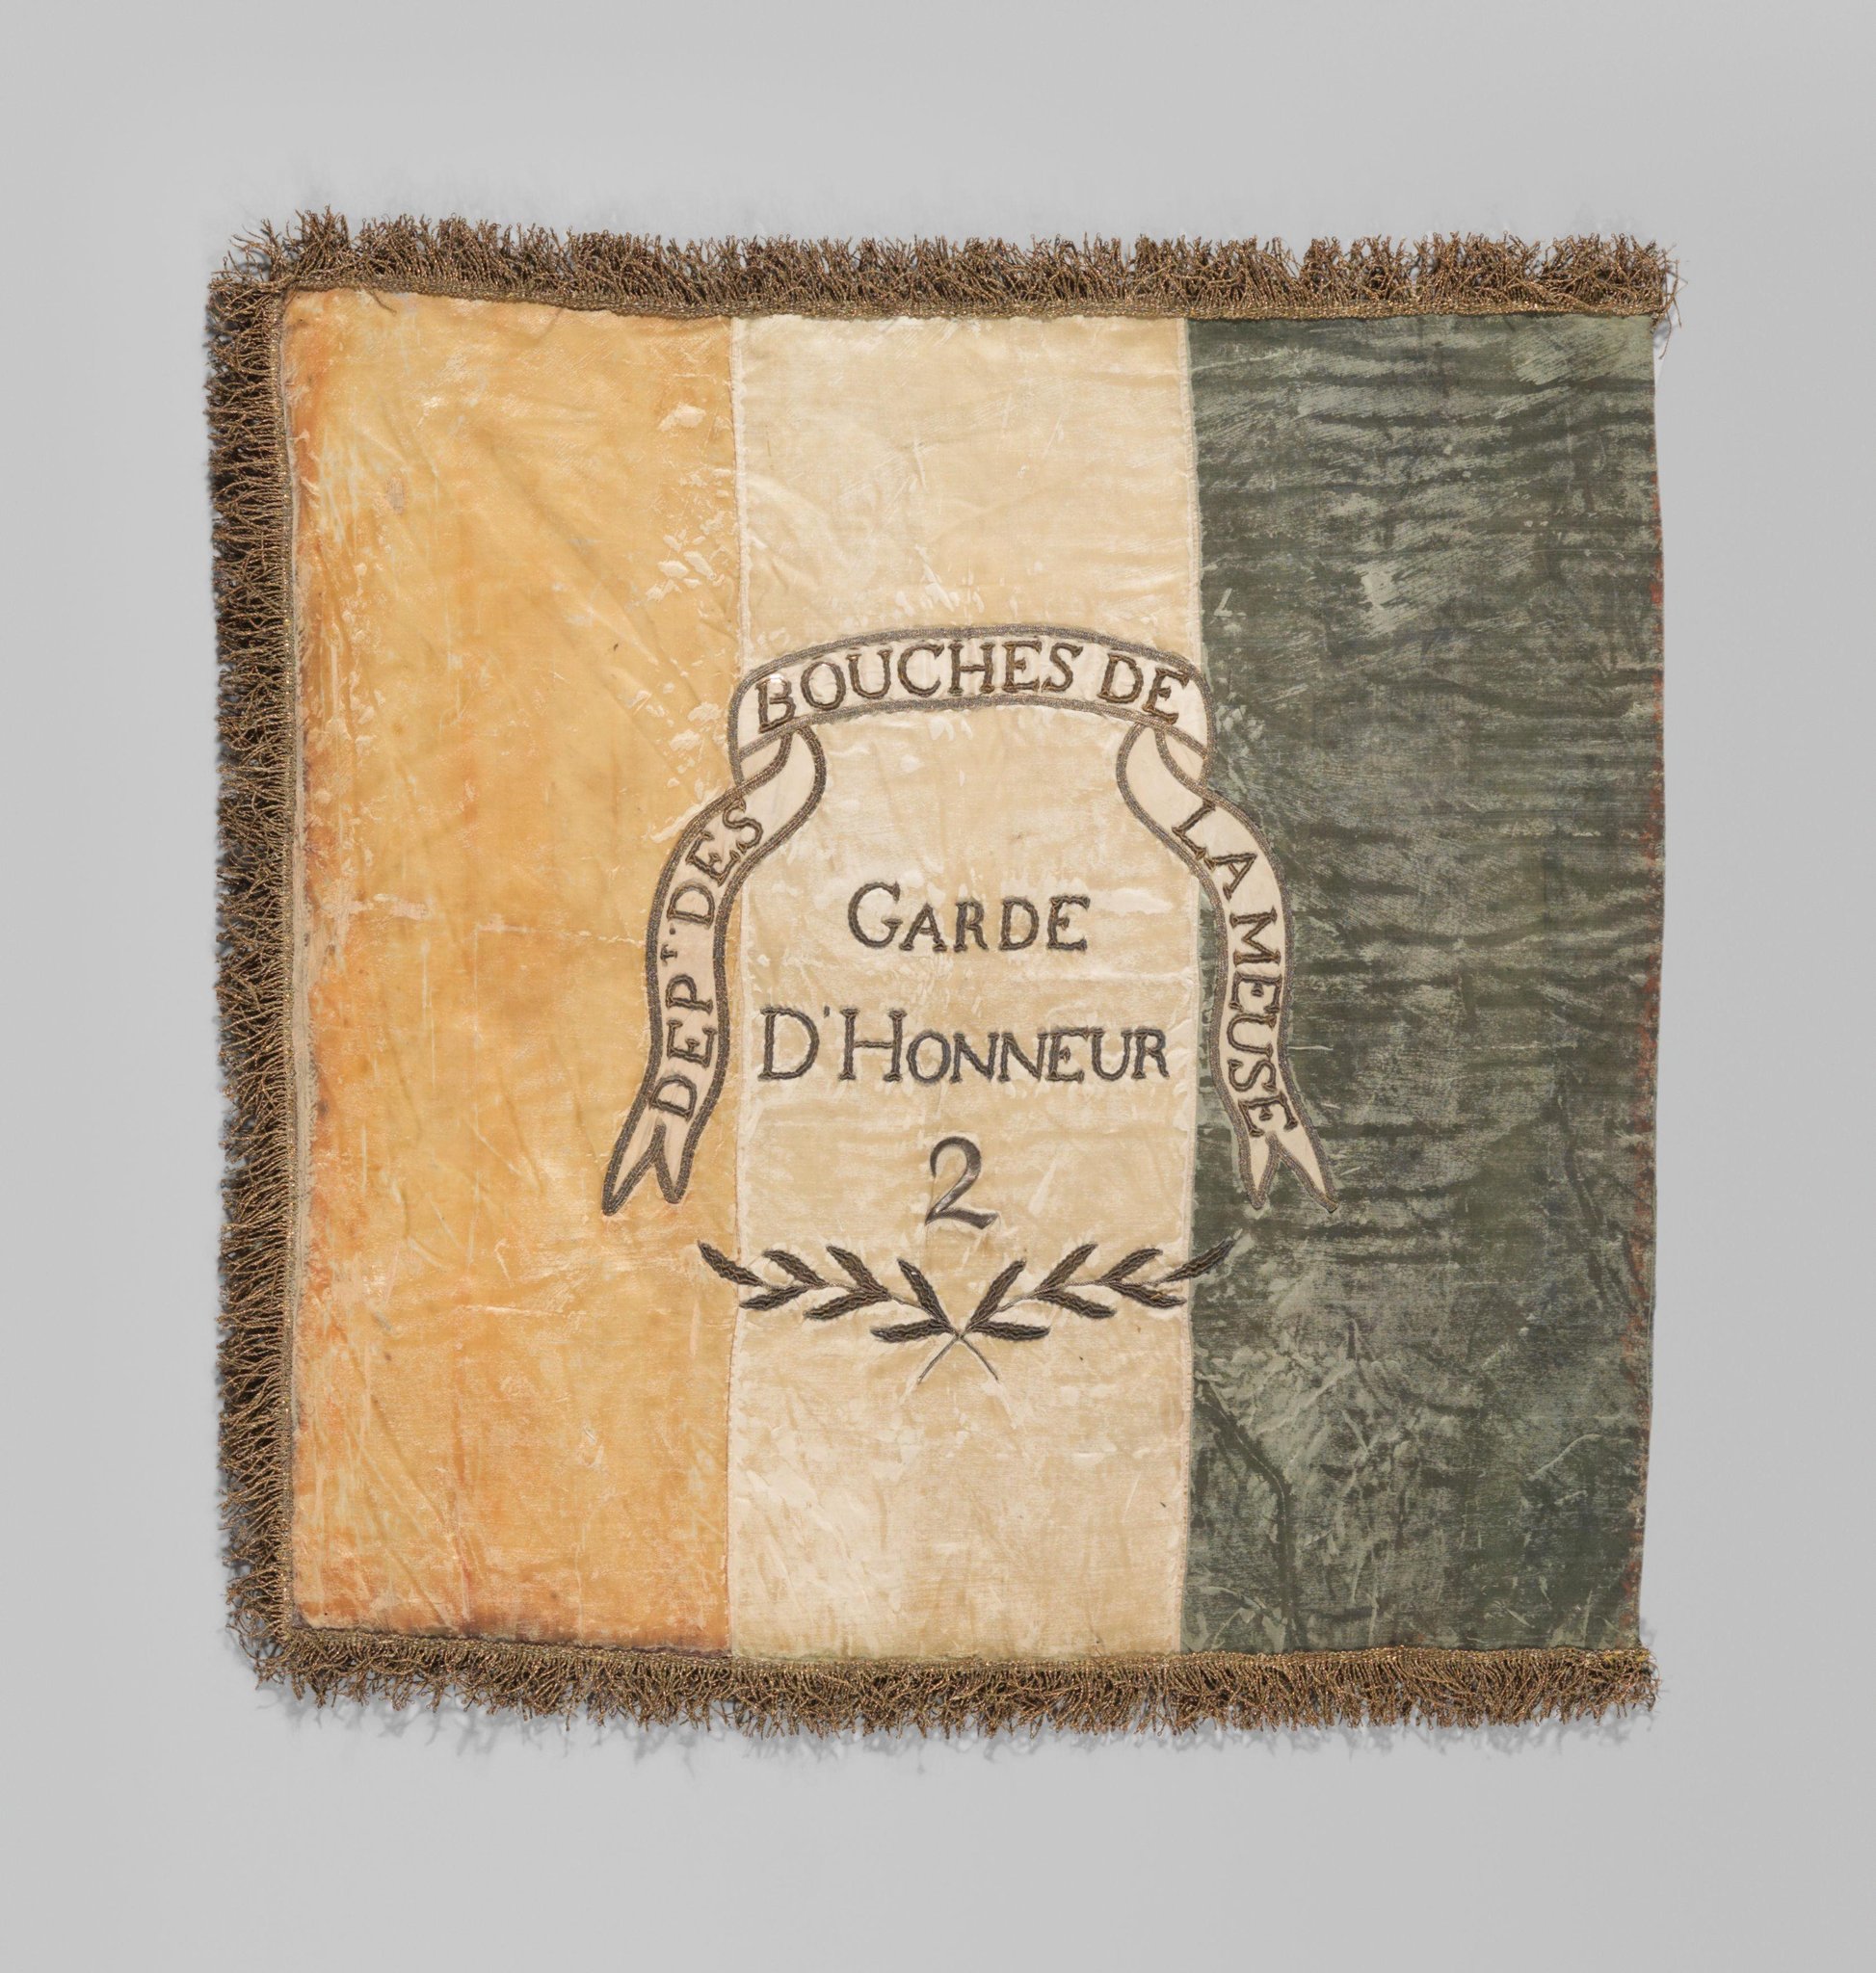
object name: banner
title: Cavalerievaandel van de Franse "Garde d'honneur" uit 1813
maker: Anonymous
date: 1813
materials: gold thread, sequin, silk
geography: netherlands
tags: monden van de maas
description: Zijden cavalerievaandel in de Franse kleuren blauw-wit-rood, toebehoord hebbende aan het 2e Detachement van de Gardes d'honneur in het Departement des Bouches de la Meuse. De drie zijden banen zijn aan de ene zijde in gouddraad en gouden lovertjes bestikt met de woorden "Garde d'honneur", waarboven een banderolle met de woorden "Dept. des Bouches de la Meuse" en daaronder een "2" en twee gekruiste takken. Aan de andere zijde is een lauwerkrans met centraal de kapitaal N (Napoleon) gestikt in gouddraad en gouden lovertjes. Aan drie zijden is het vaandel omstikt met een franje van gouddraad.